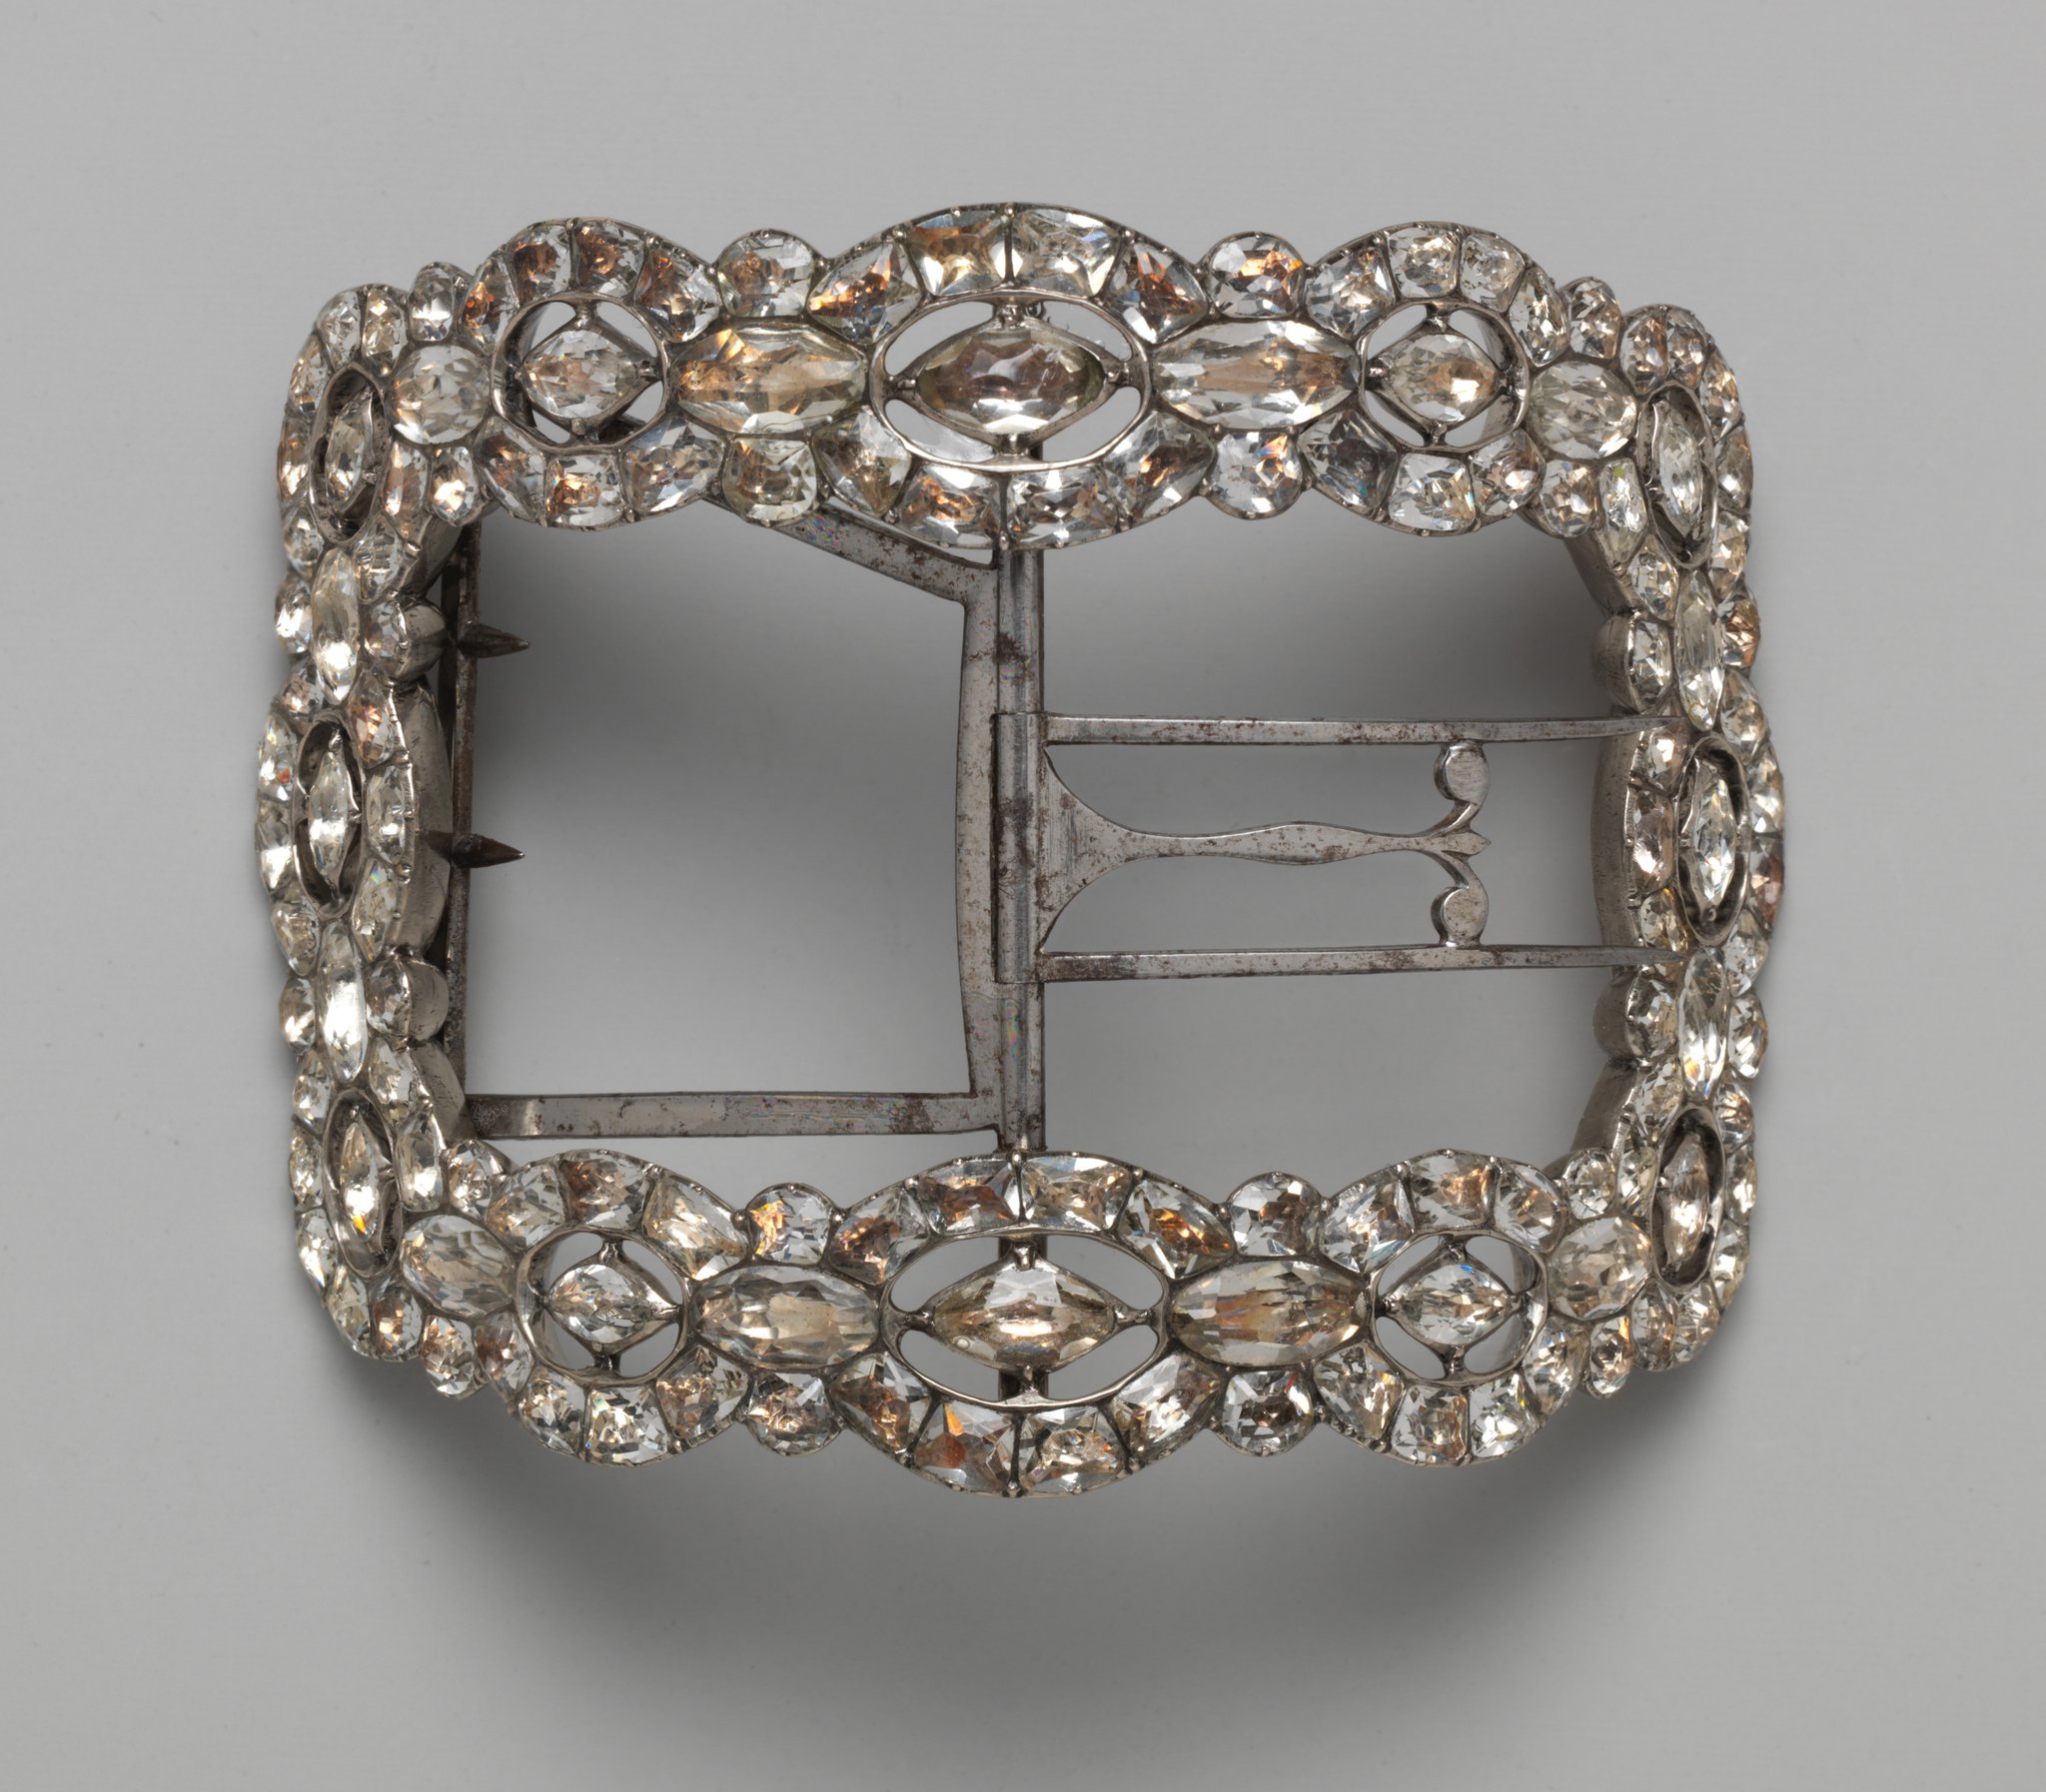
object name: shoe buckle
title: Shoe buckles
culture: british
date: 1767-1800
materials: metal, paste